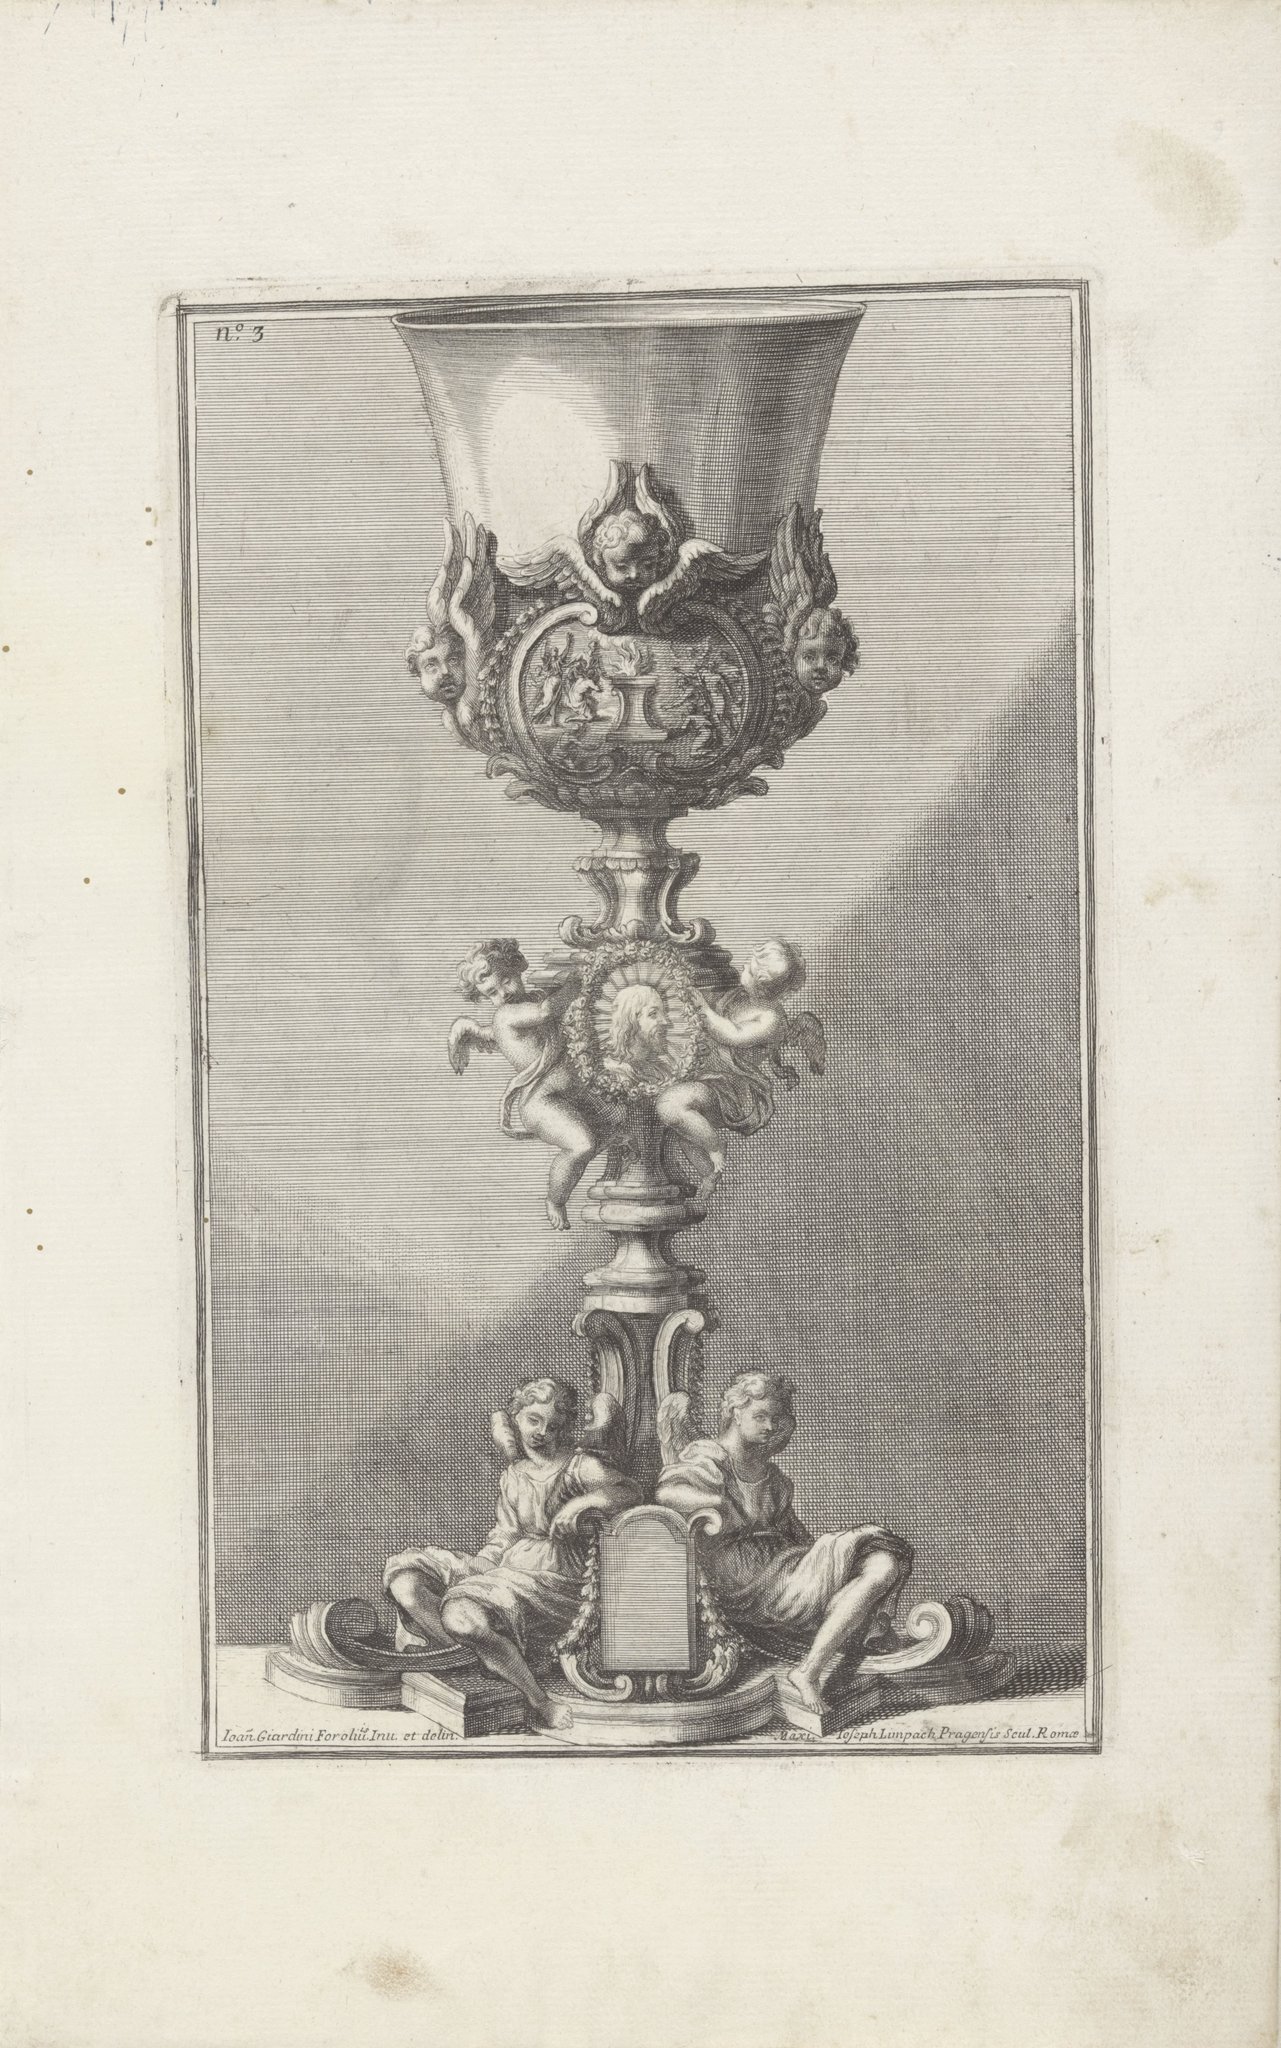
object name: ornament print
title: Diverse kerkelijke voorwerpen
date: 1714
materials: paper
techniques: etching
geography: rome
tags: chalice, christ, cupids: 'amores', 'amoretti', 'putti', angels, sacrifice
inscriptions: collector's mark: Lugt 2228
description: Prent maakt deel uit van een reeks van 100 ornamentprenten naar ontwerp van Giovanni Giardini.